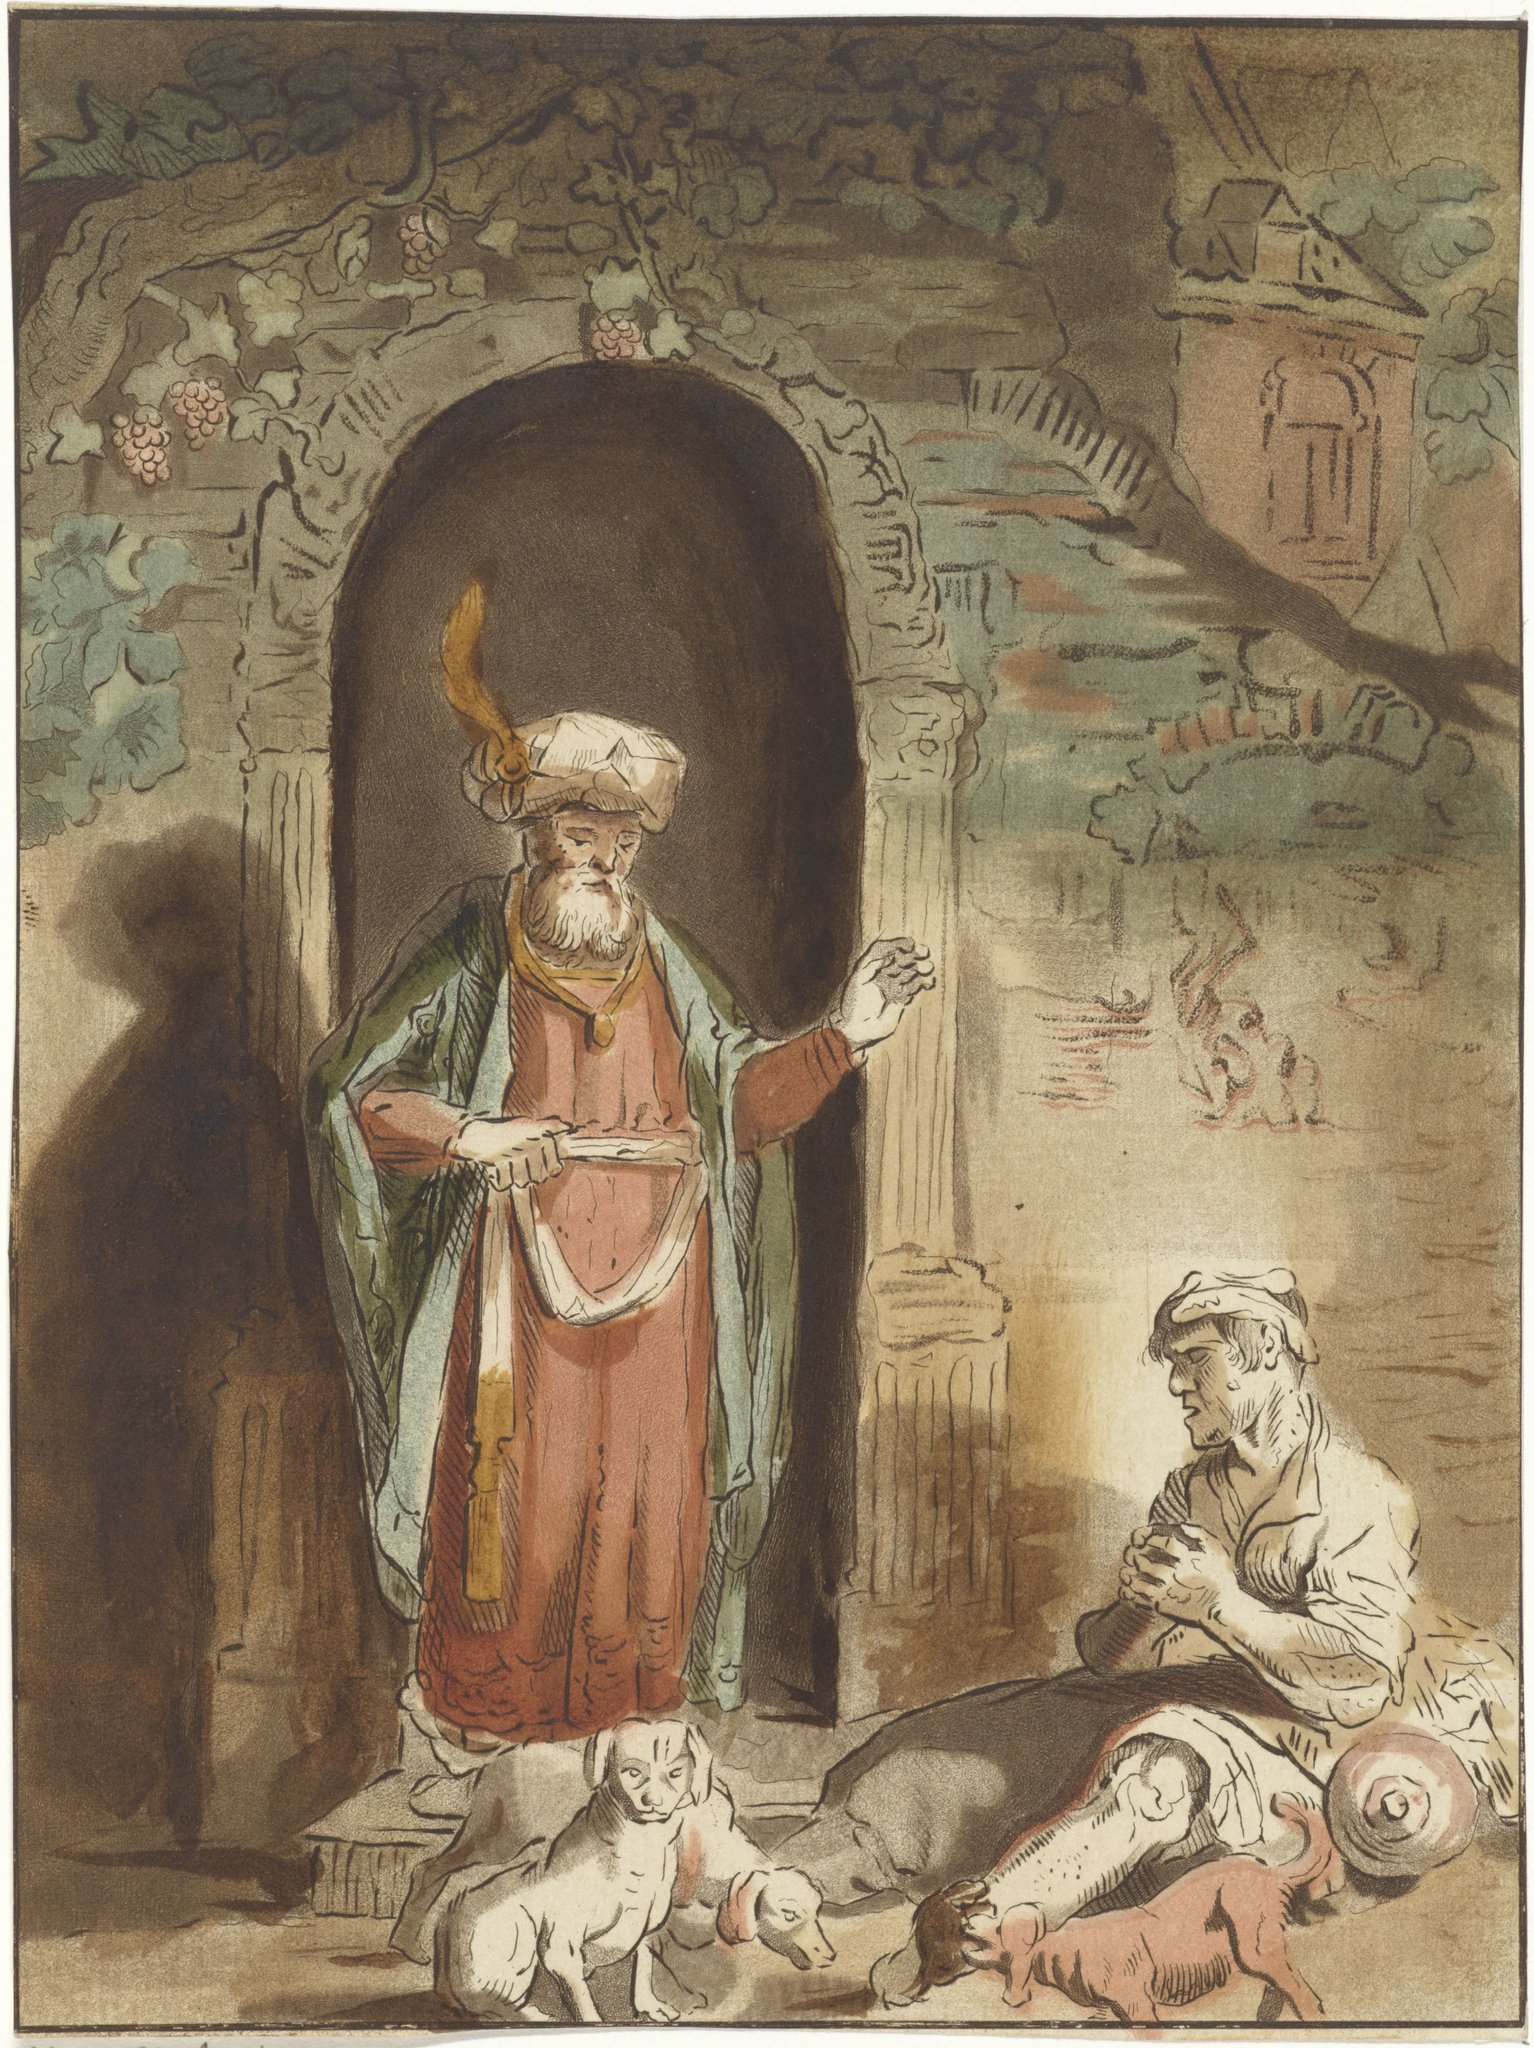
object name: print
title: De rijke man en de arme Lazarus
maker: bernhard schreuder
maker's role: print maker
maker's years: -1780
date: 1767-1780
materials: paper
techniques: etching, hand coloring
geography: netherlands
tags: the rich man (dives) is feasting, while poor lazarus is starving at the gate (dogs licking lazarus' sores) (luke 16:19-31)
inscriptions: collector's mark: Lugt 2228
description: De rijke man staat in zijn deuropening en kijkt neer op Lazarus, die op de grond zit en wiens zweren door de honden worden gelikt.